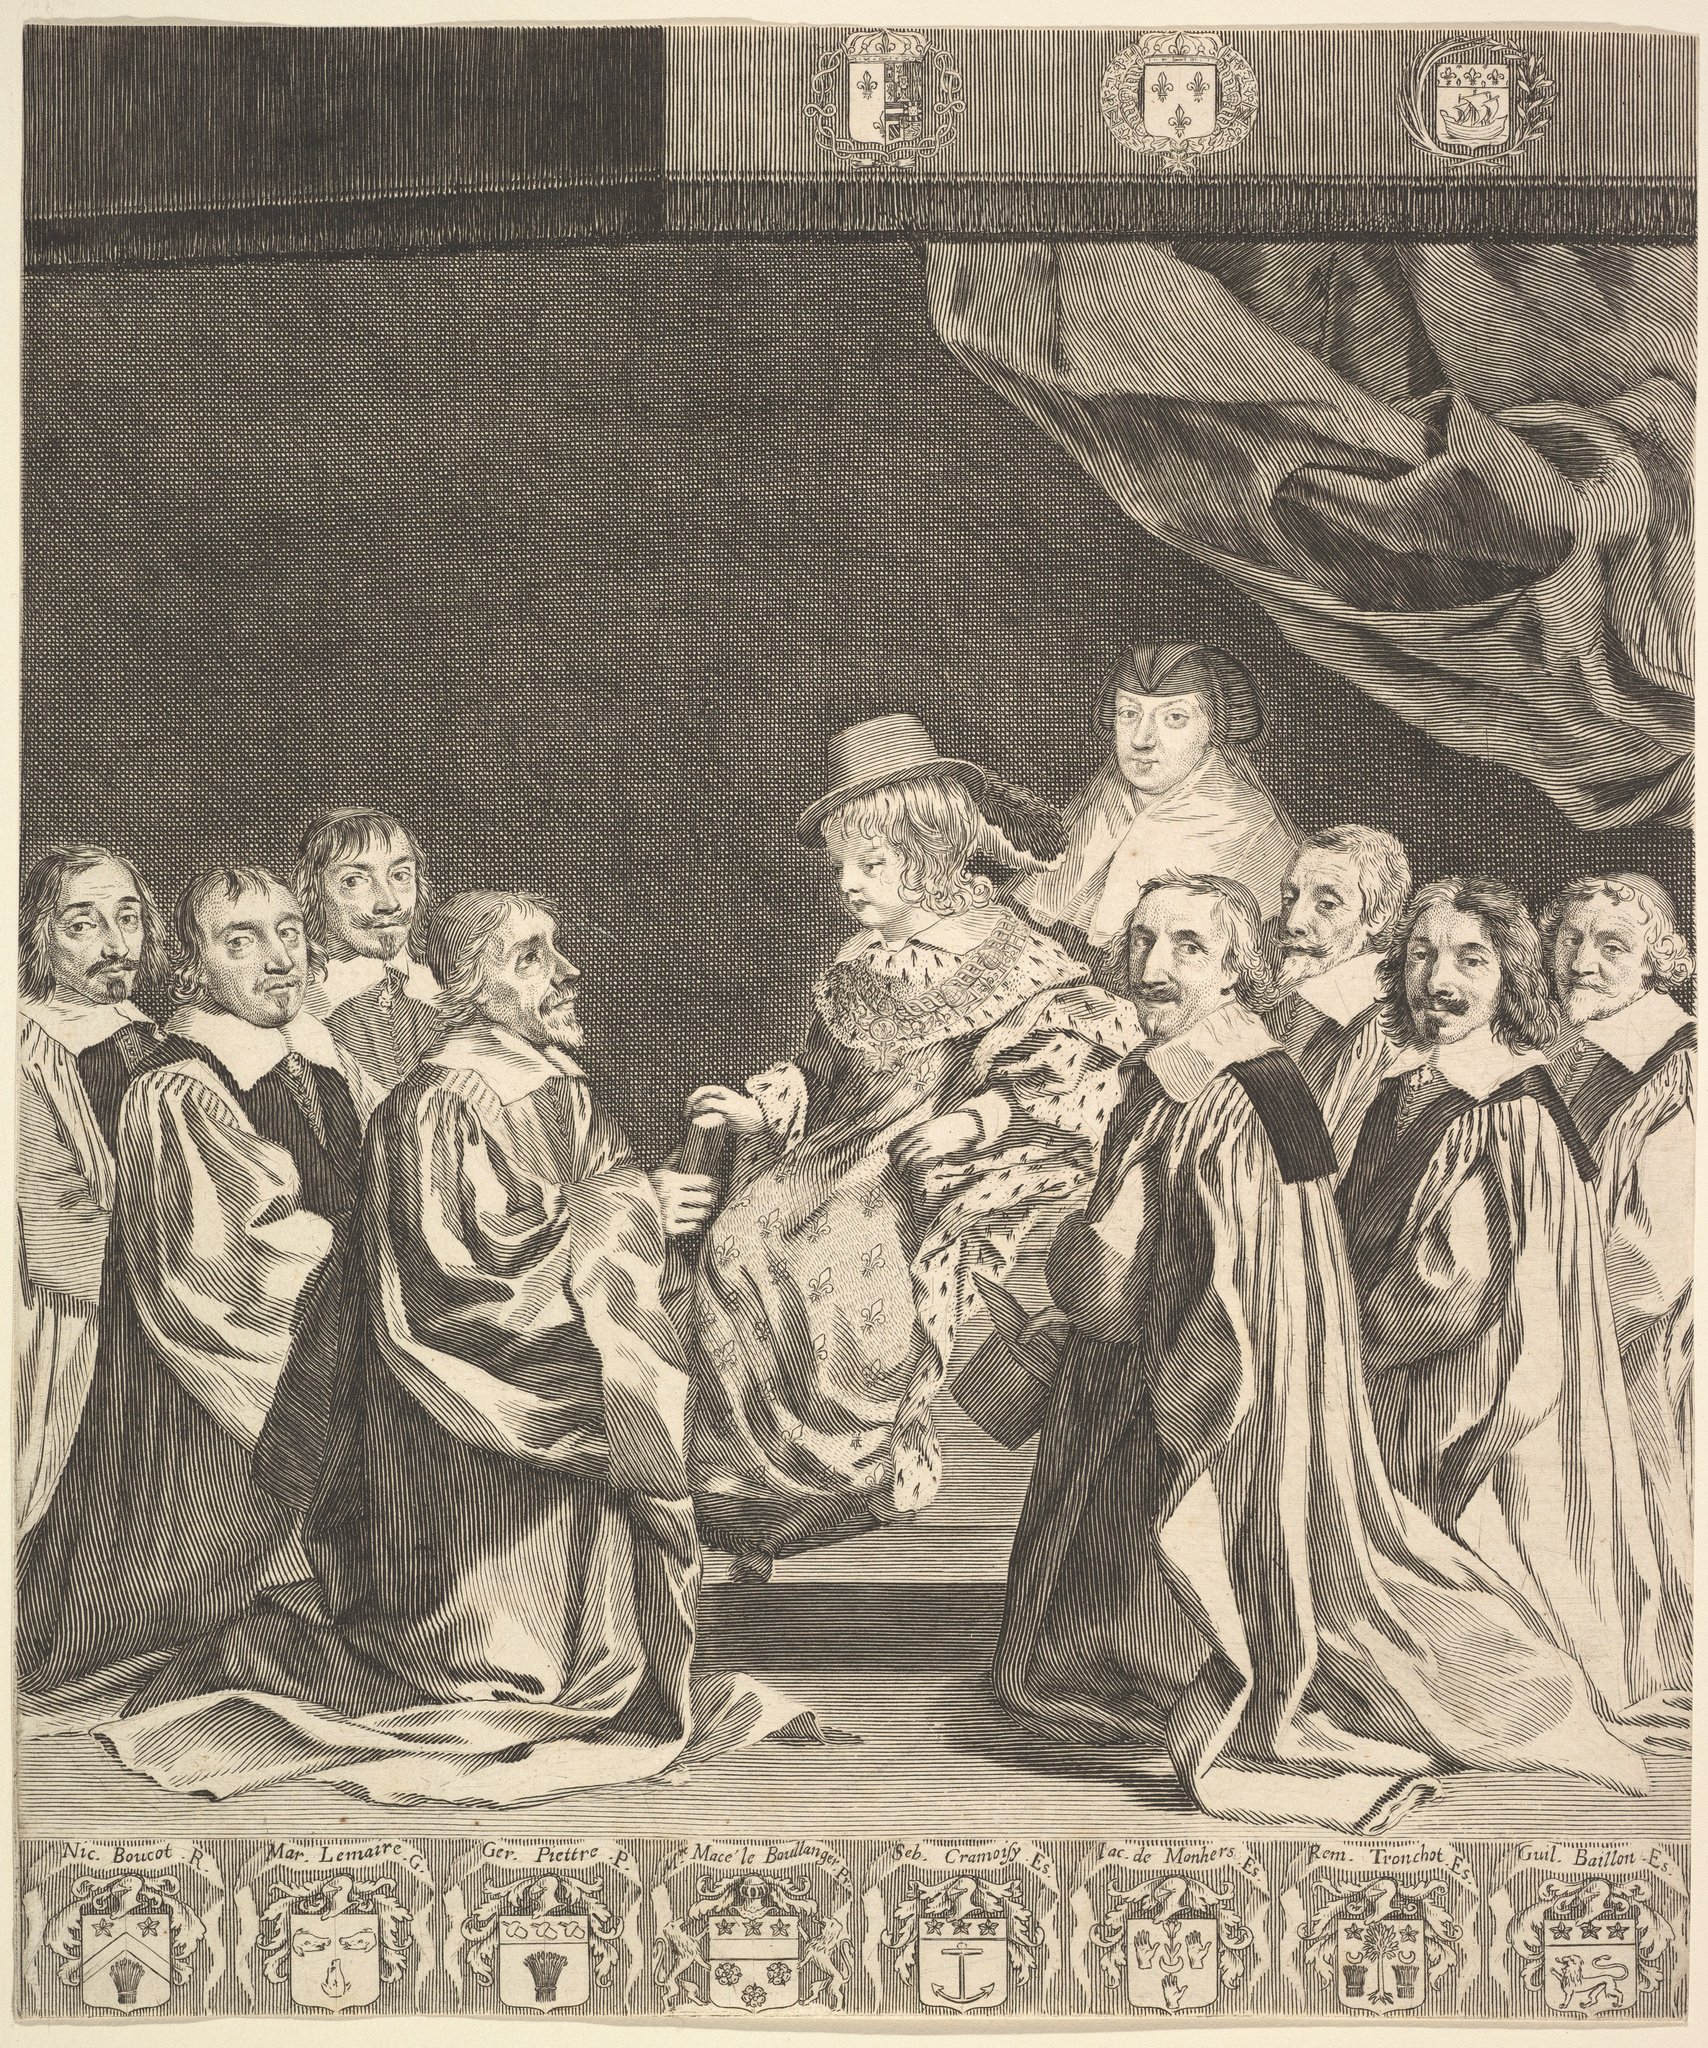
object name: print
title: Frontispiece: Les Ordonnances royaux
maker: claude mellan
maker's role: artist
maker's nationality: french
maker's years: 1598-1688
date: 1644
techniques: engraving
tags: girls,men,coat of arms